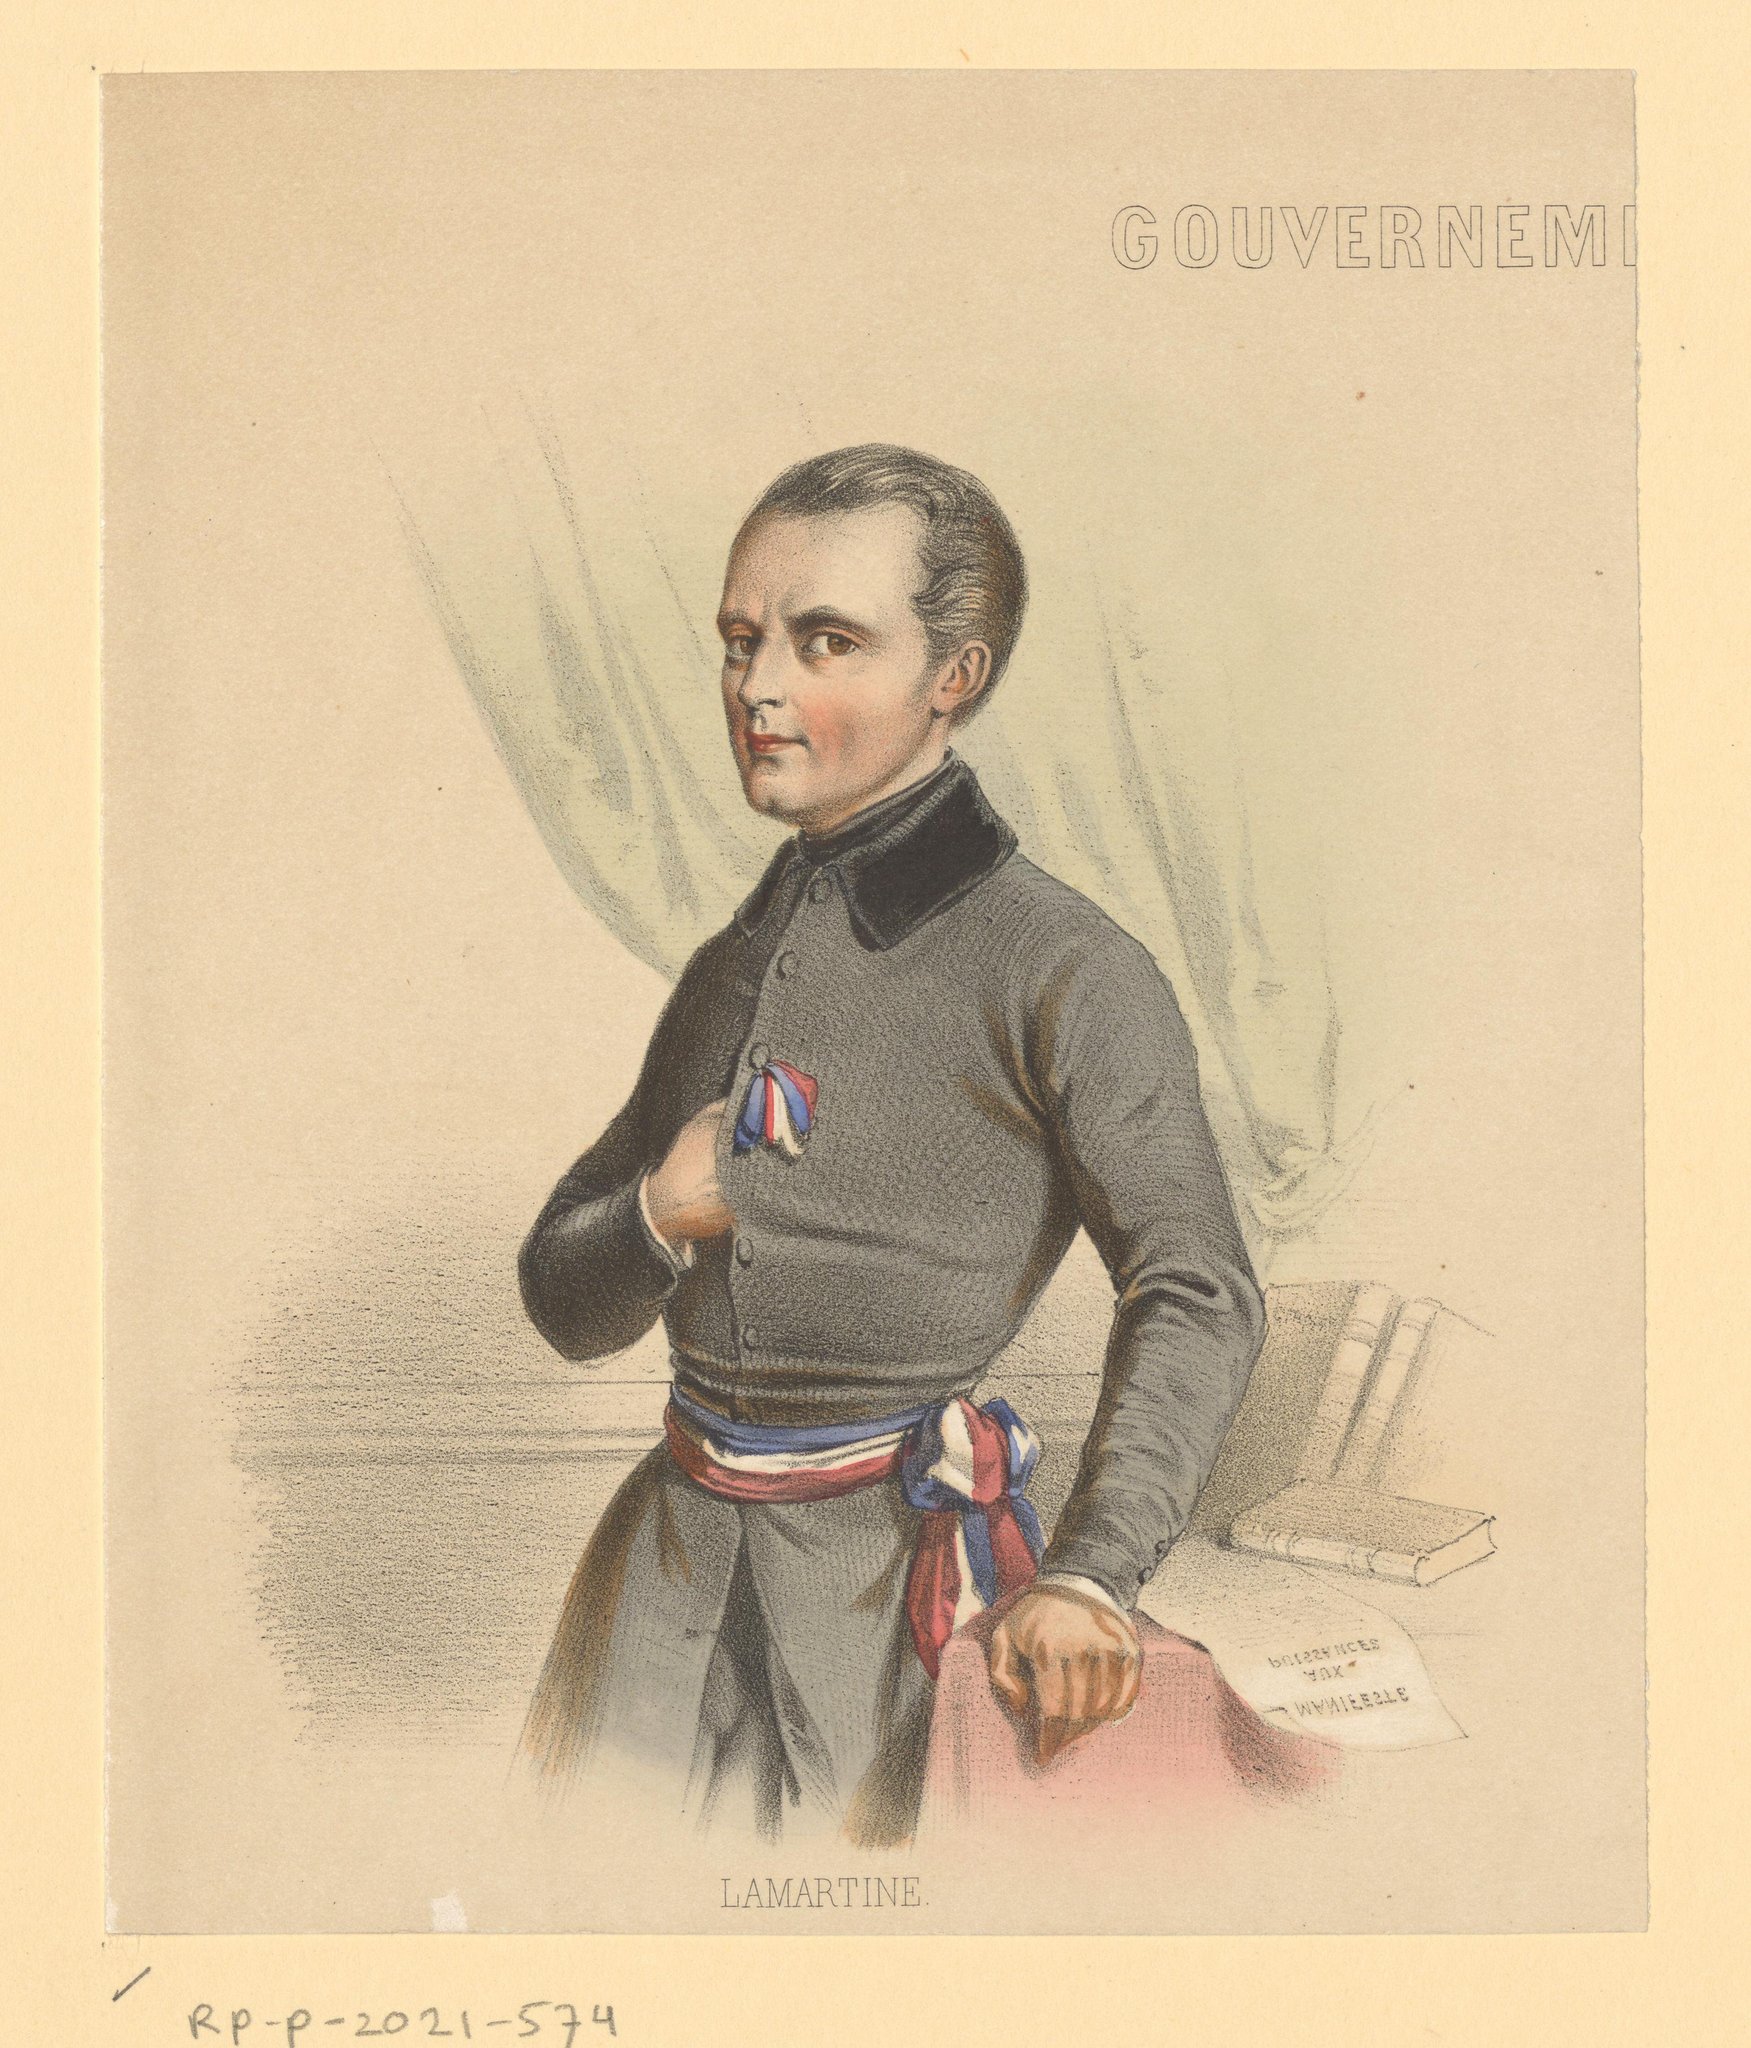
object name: print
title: Portret van Alphonse de Lamartine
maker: Anonymous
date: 1830-1899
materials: paper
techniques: hand coloring, lithograph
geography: france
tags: paris, flag, colours (as symbol of the state, etc.) (+ nation; national), historical persons, portrait of a writer, book, politician, e.g. party leader